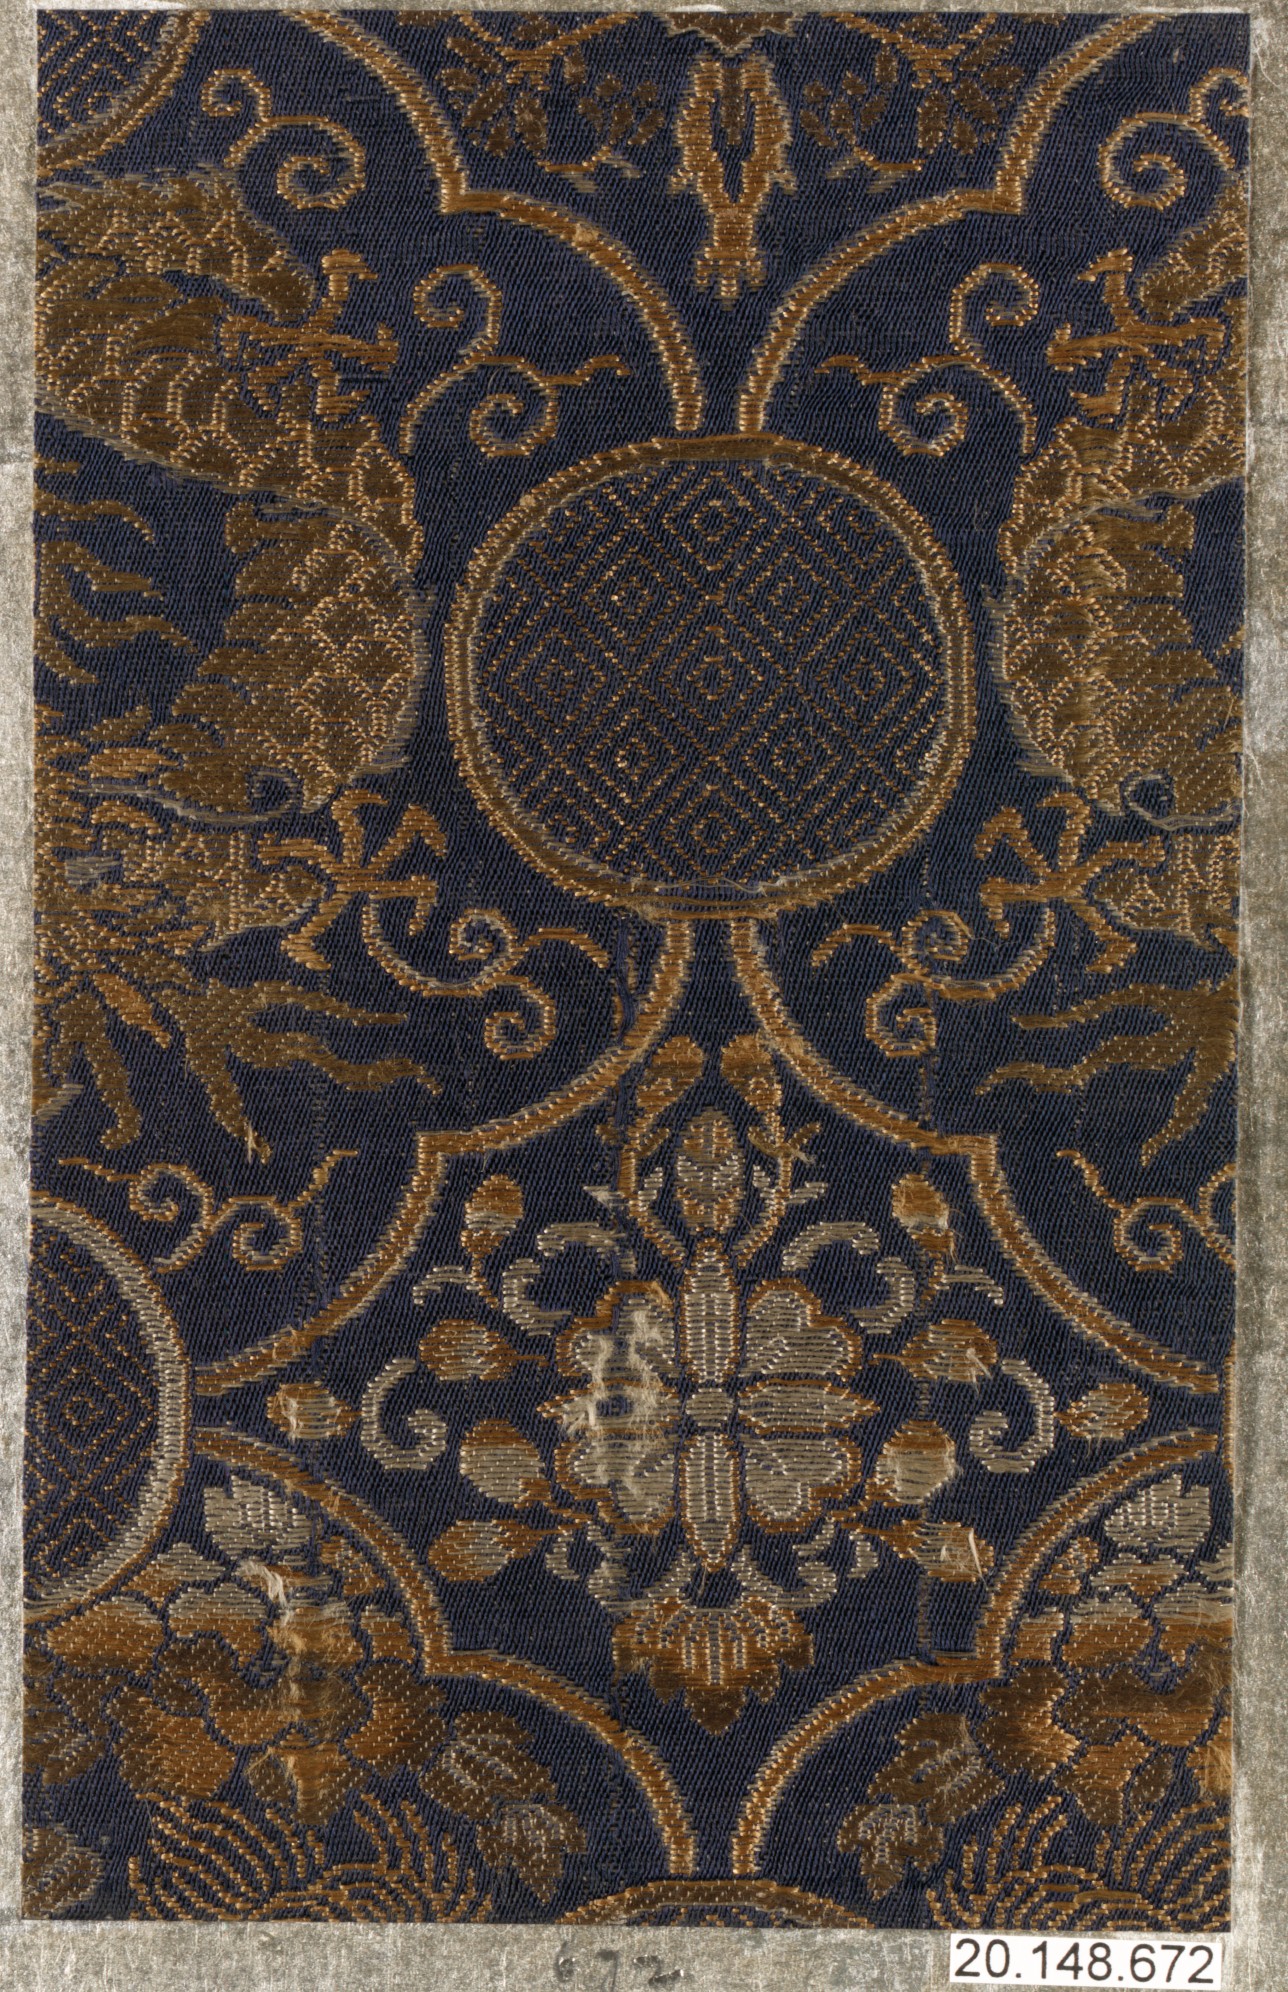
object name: piece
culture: japanese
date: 1801-1900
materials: silk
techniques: compound weave